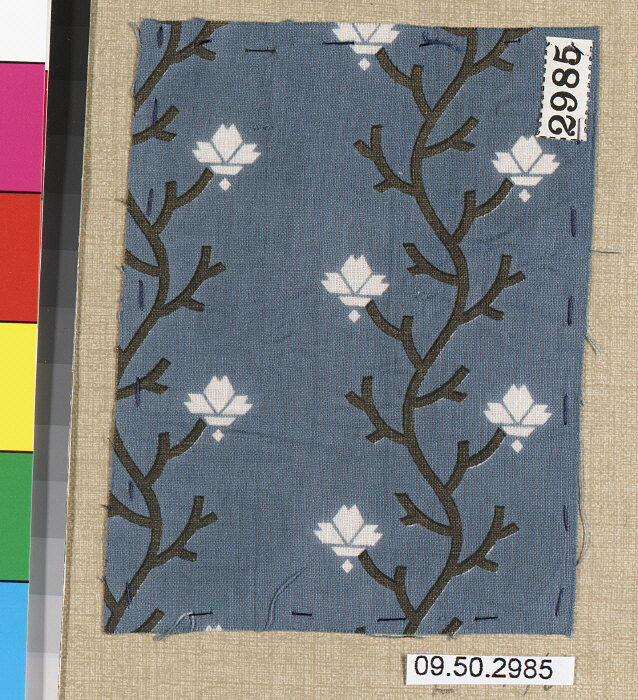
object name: piece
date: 1801-1900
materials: cotton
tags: plants